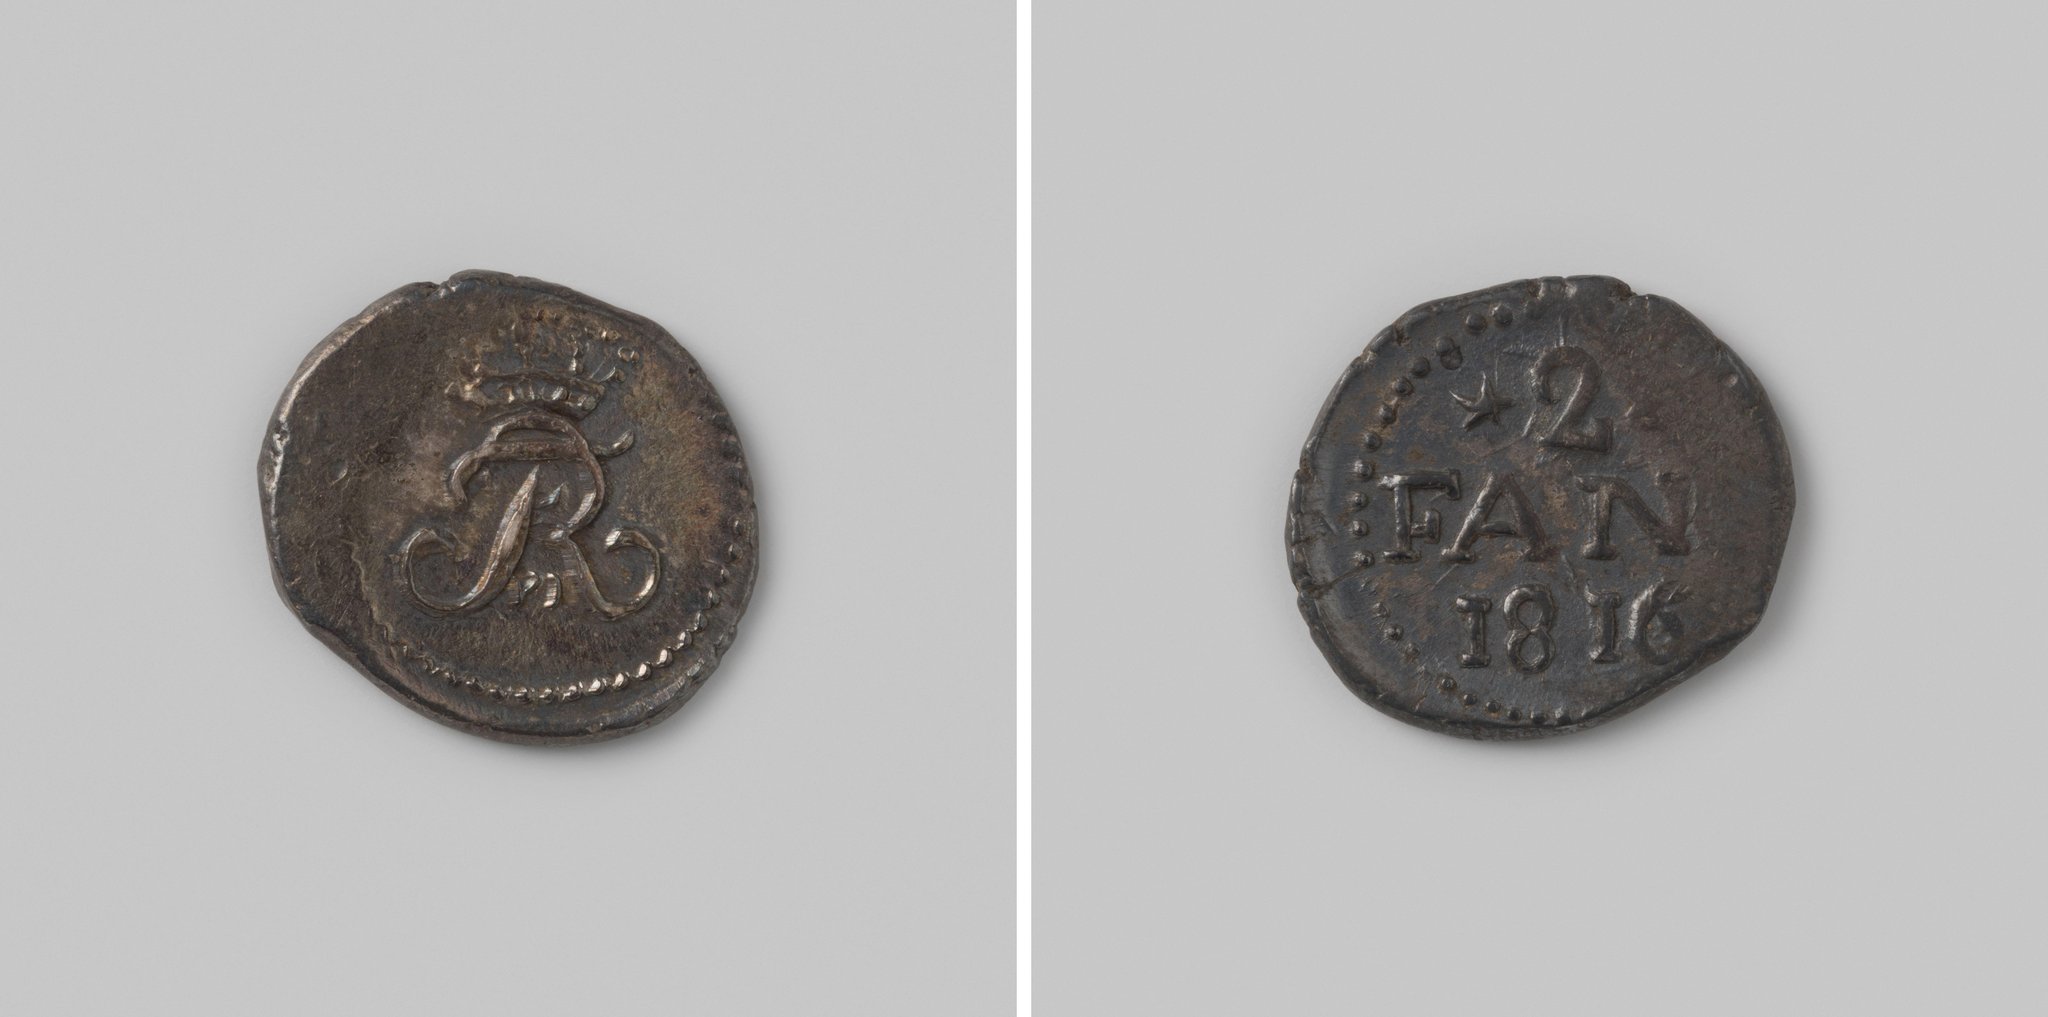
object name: coin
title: 2 fano uit Tranquebar, Deens-India van de Deense Aziatische Compagnie (DAC) op naam van koning Frederik VI, 1816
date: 1816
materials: silver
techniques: striking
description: Zilveren munt. Voorzijde: gekroond monogram van de koning. Keerzijde: in twee regels waarde-aanduiding: 2 fan[o]. Daaronder jaartal.